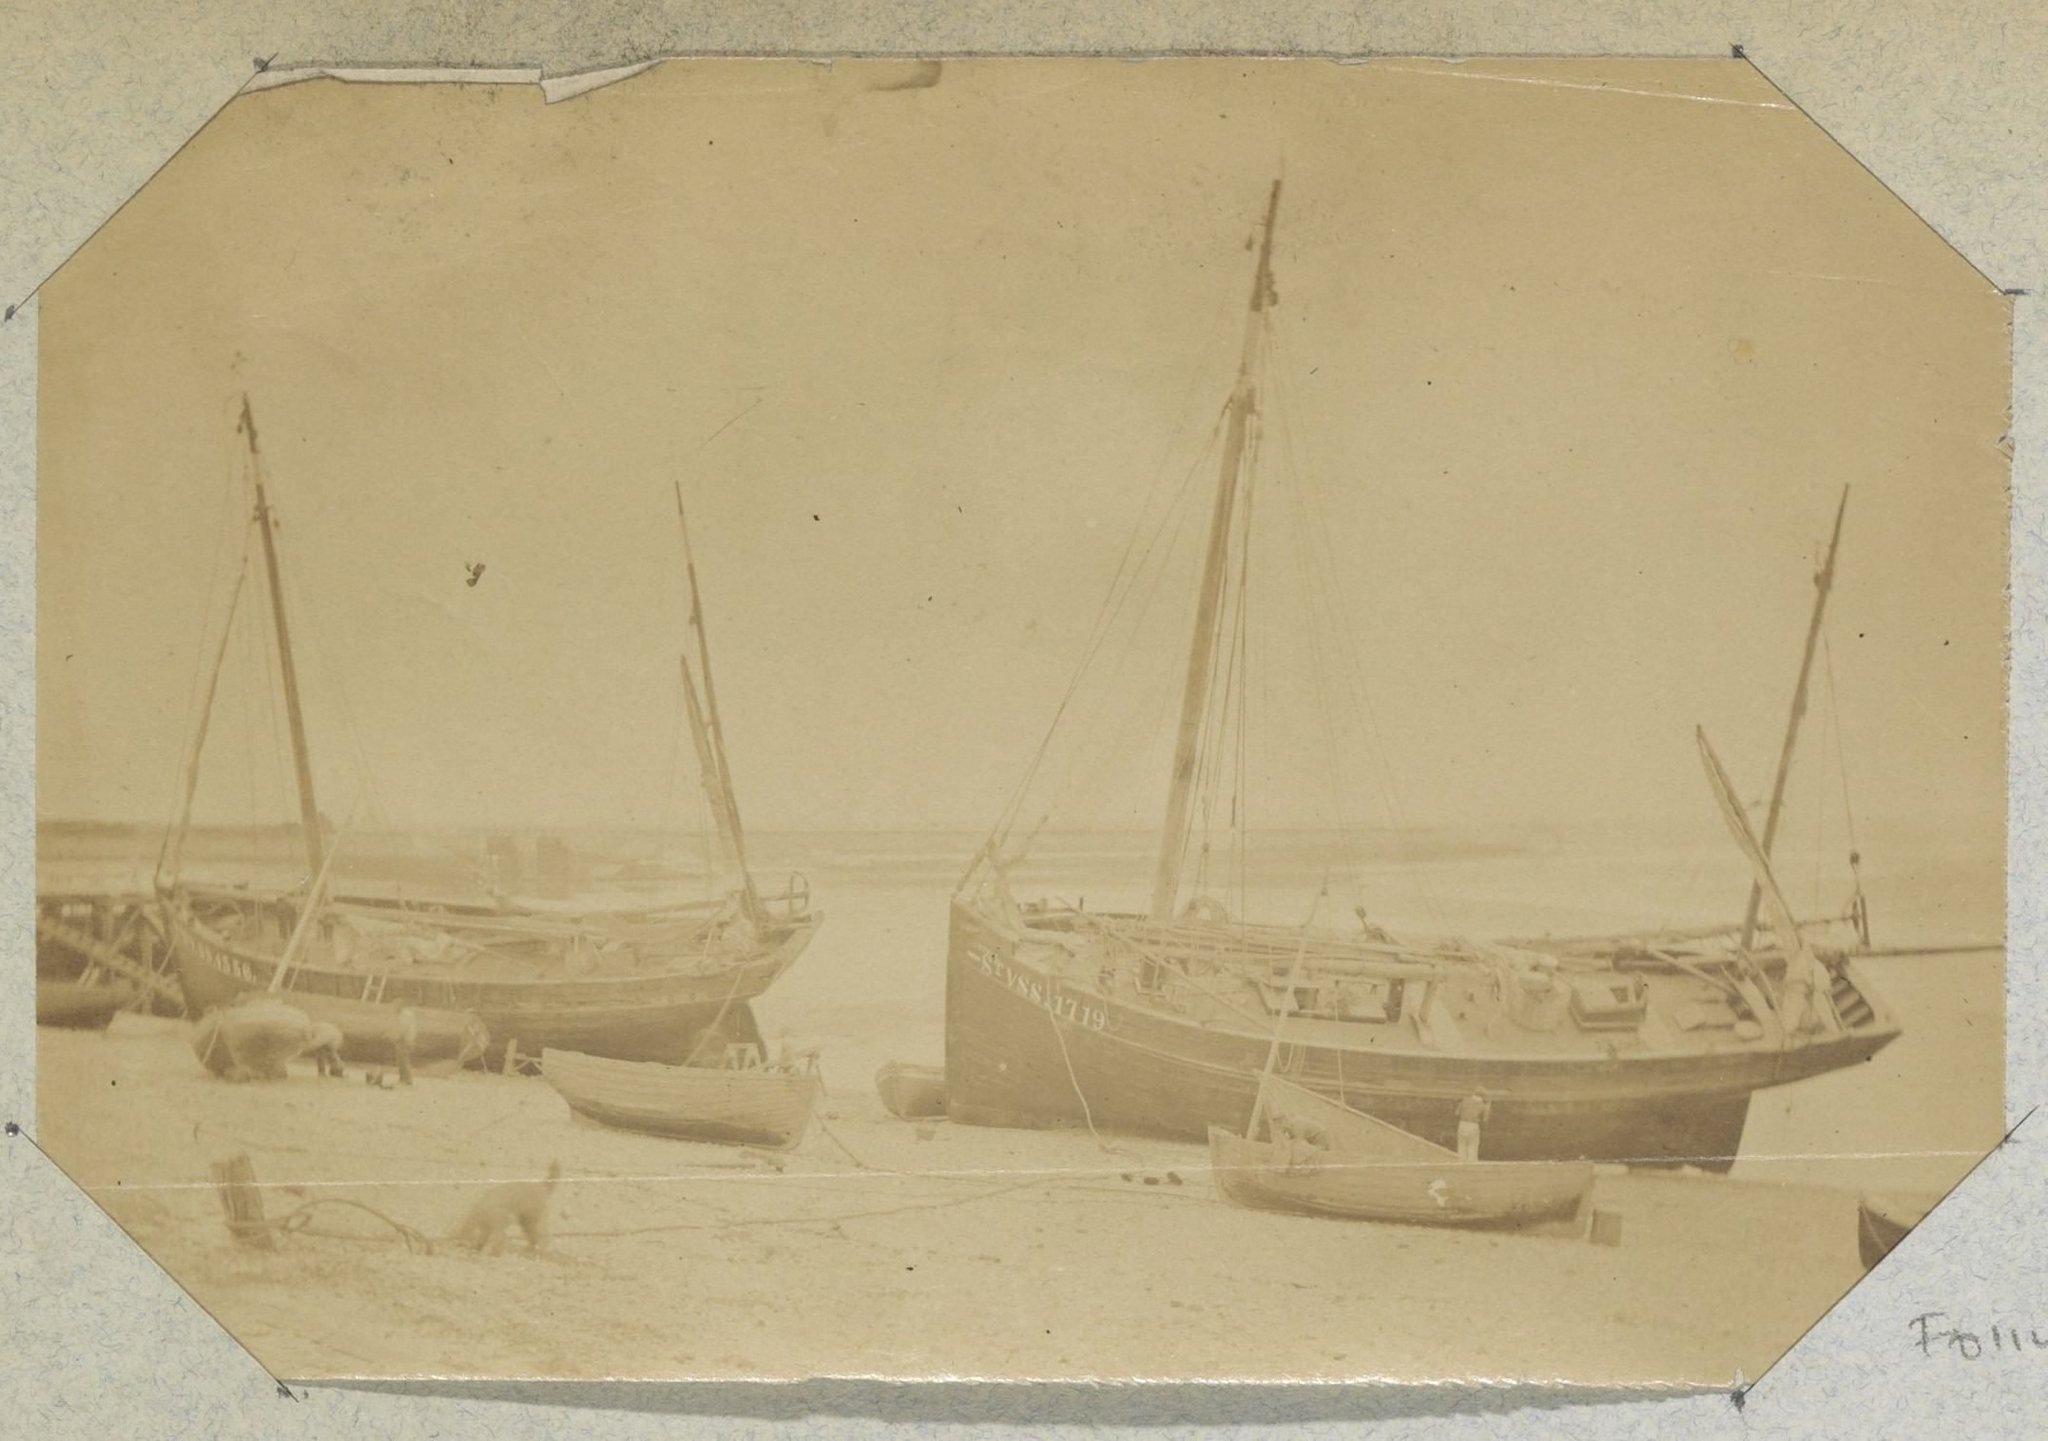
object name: photograph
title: Schepen op het strand, vermoedelijk bij Saint Valery sur Somme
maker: Anonymous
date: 1880-1900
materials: paper, photographic support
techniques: albumen print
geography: france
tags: sailing-ship, sailing-boat, rural housing, e.g. country-house, villa, cottage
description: Onderdeel van Album van een Franse amateur met foto's van Frankrijk, Algerije, Palmyra, de Wereldtentoonstelling van 1900 en van bekende Fransen.